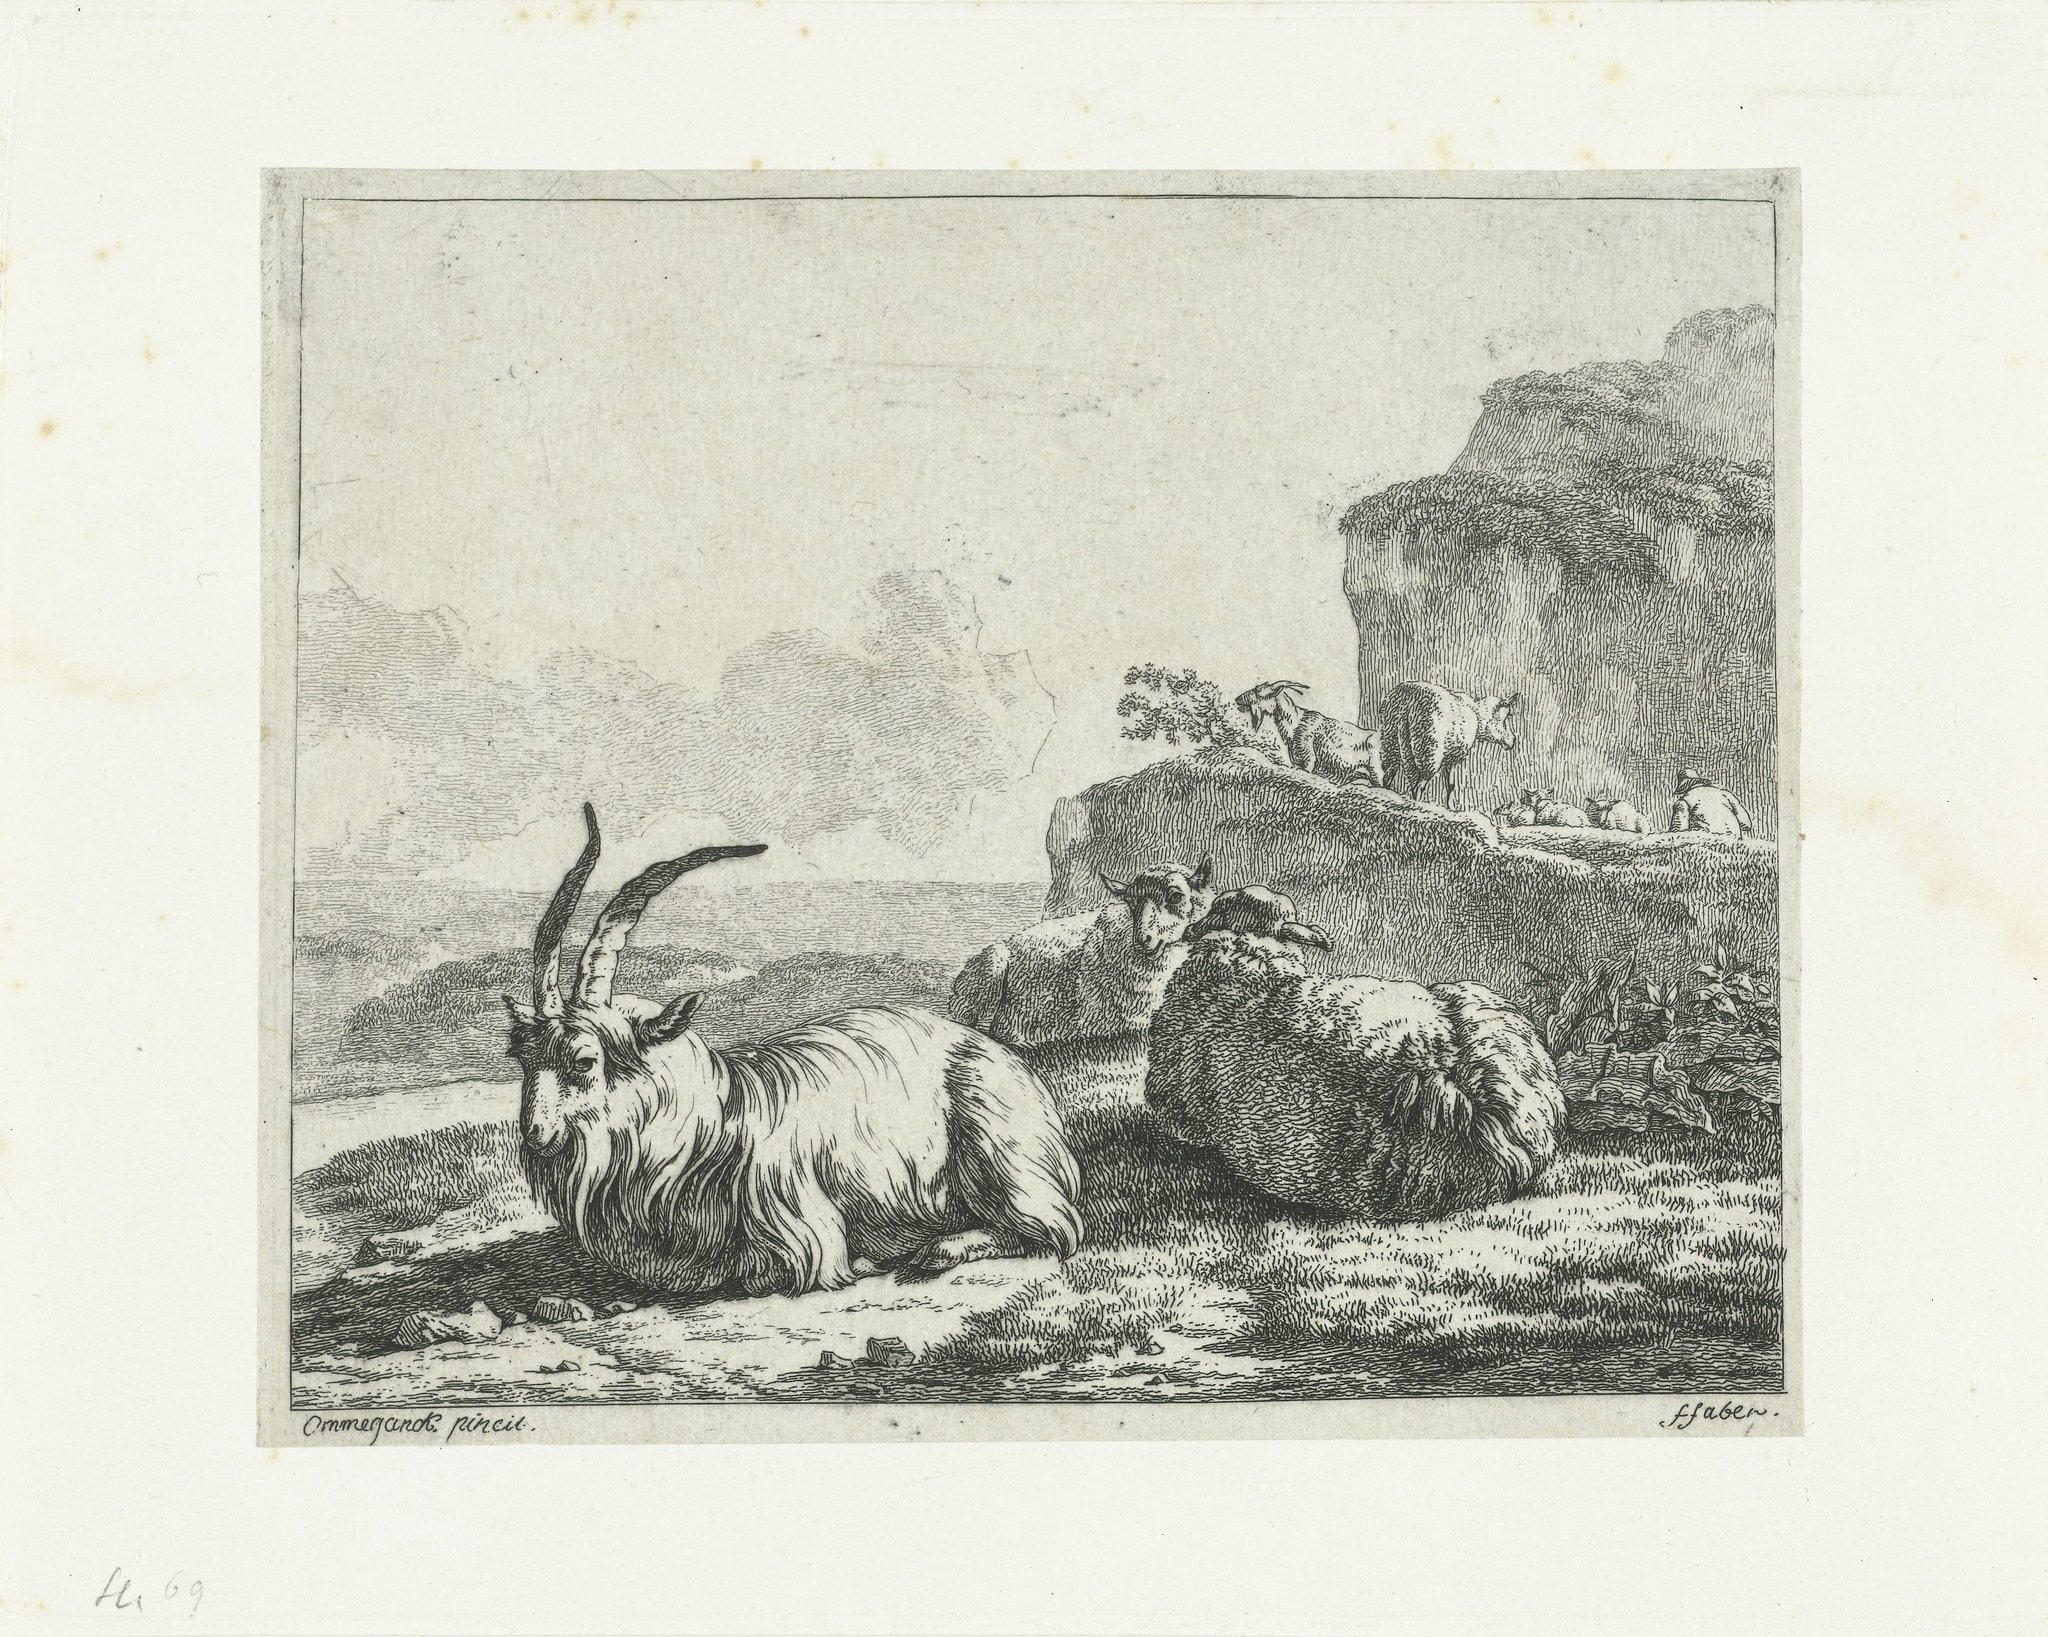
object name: print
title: Landschap met bok en twee schapen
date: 1828-1831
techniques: printmaking, etching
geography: brussels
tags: he-goat, billy-goat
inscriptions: collector's mark: Lugt 1485, collector's mark: Lugt 2228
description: Berglandschap met op de voorgrond twee liggende schapen en een geit. Op het bergpad op de achtergrond een herder met zijn kudde.